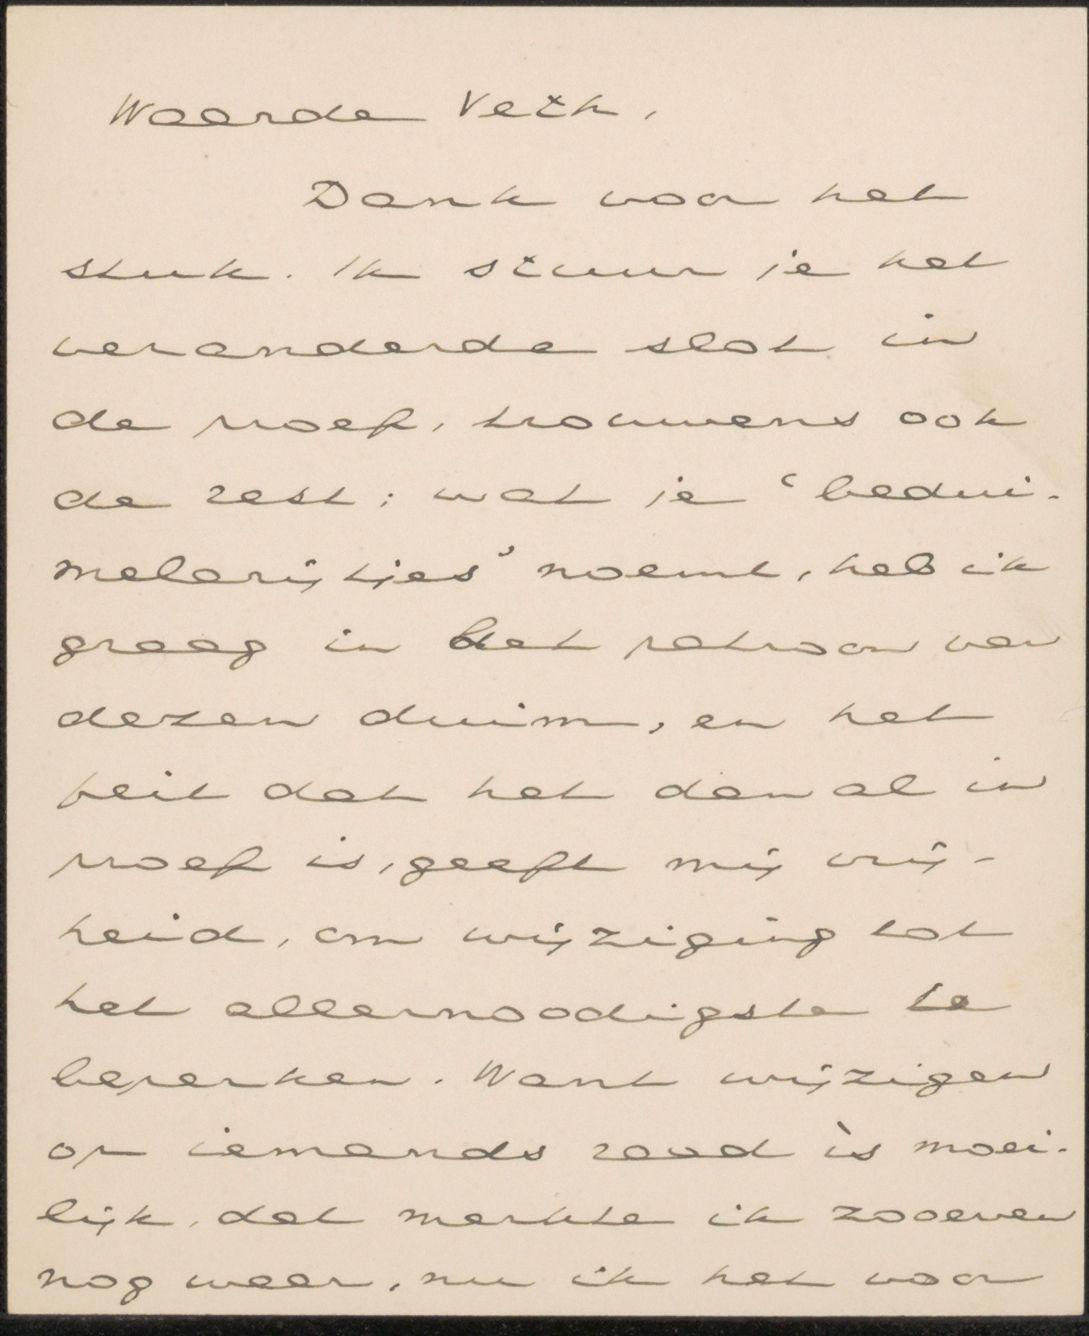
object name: letter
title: Brief aan Jan Veth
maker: johan huizinga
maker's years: 1872-1945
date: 1916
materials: ink, paper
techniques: pen, writing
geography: leiden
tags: painter, draughtsman, designer, jan veth, amsterdam, the hague, willem byvanck, printed matter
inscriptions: collector's mark: ‘RPK’